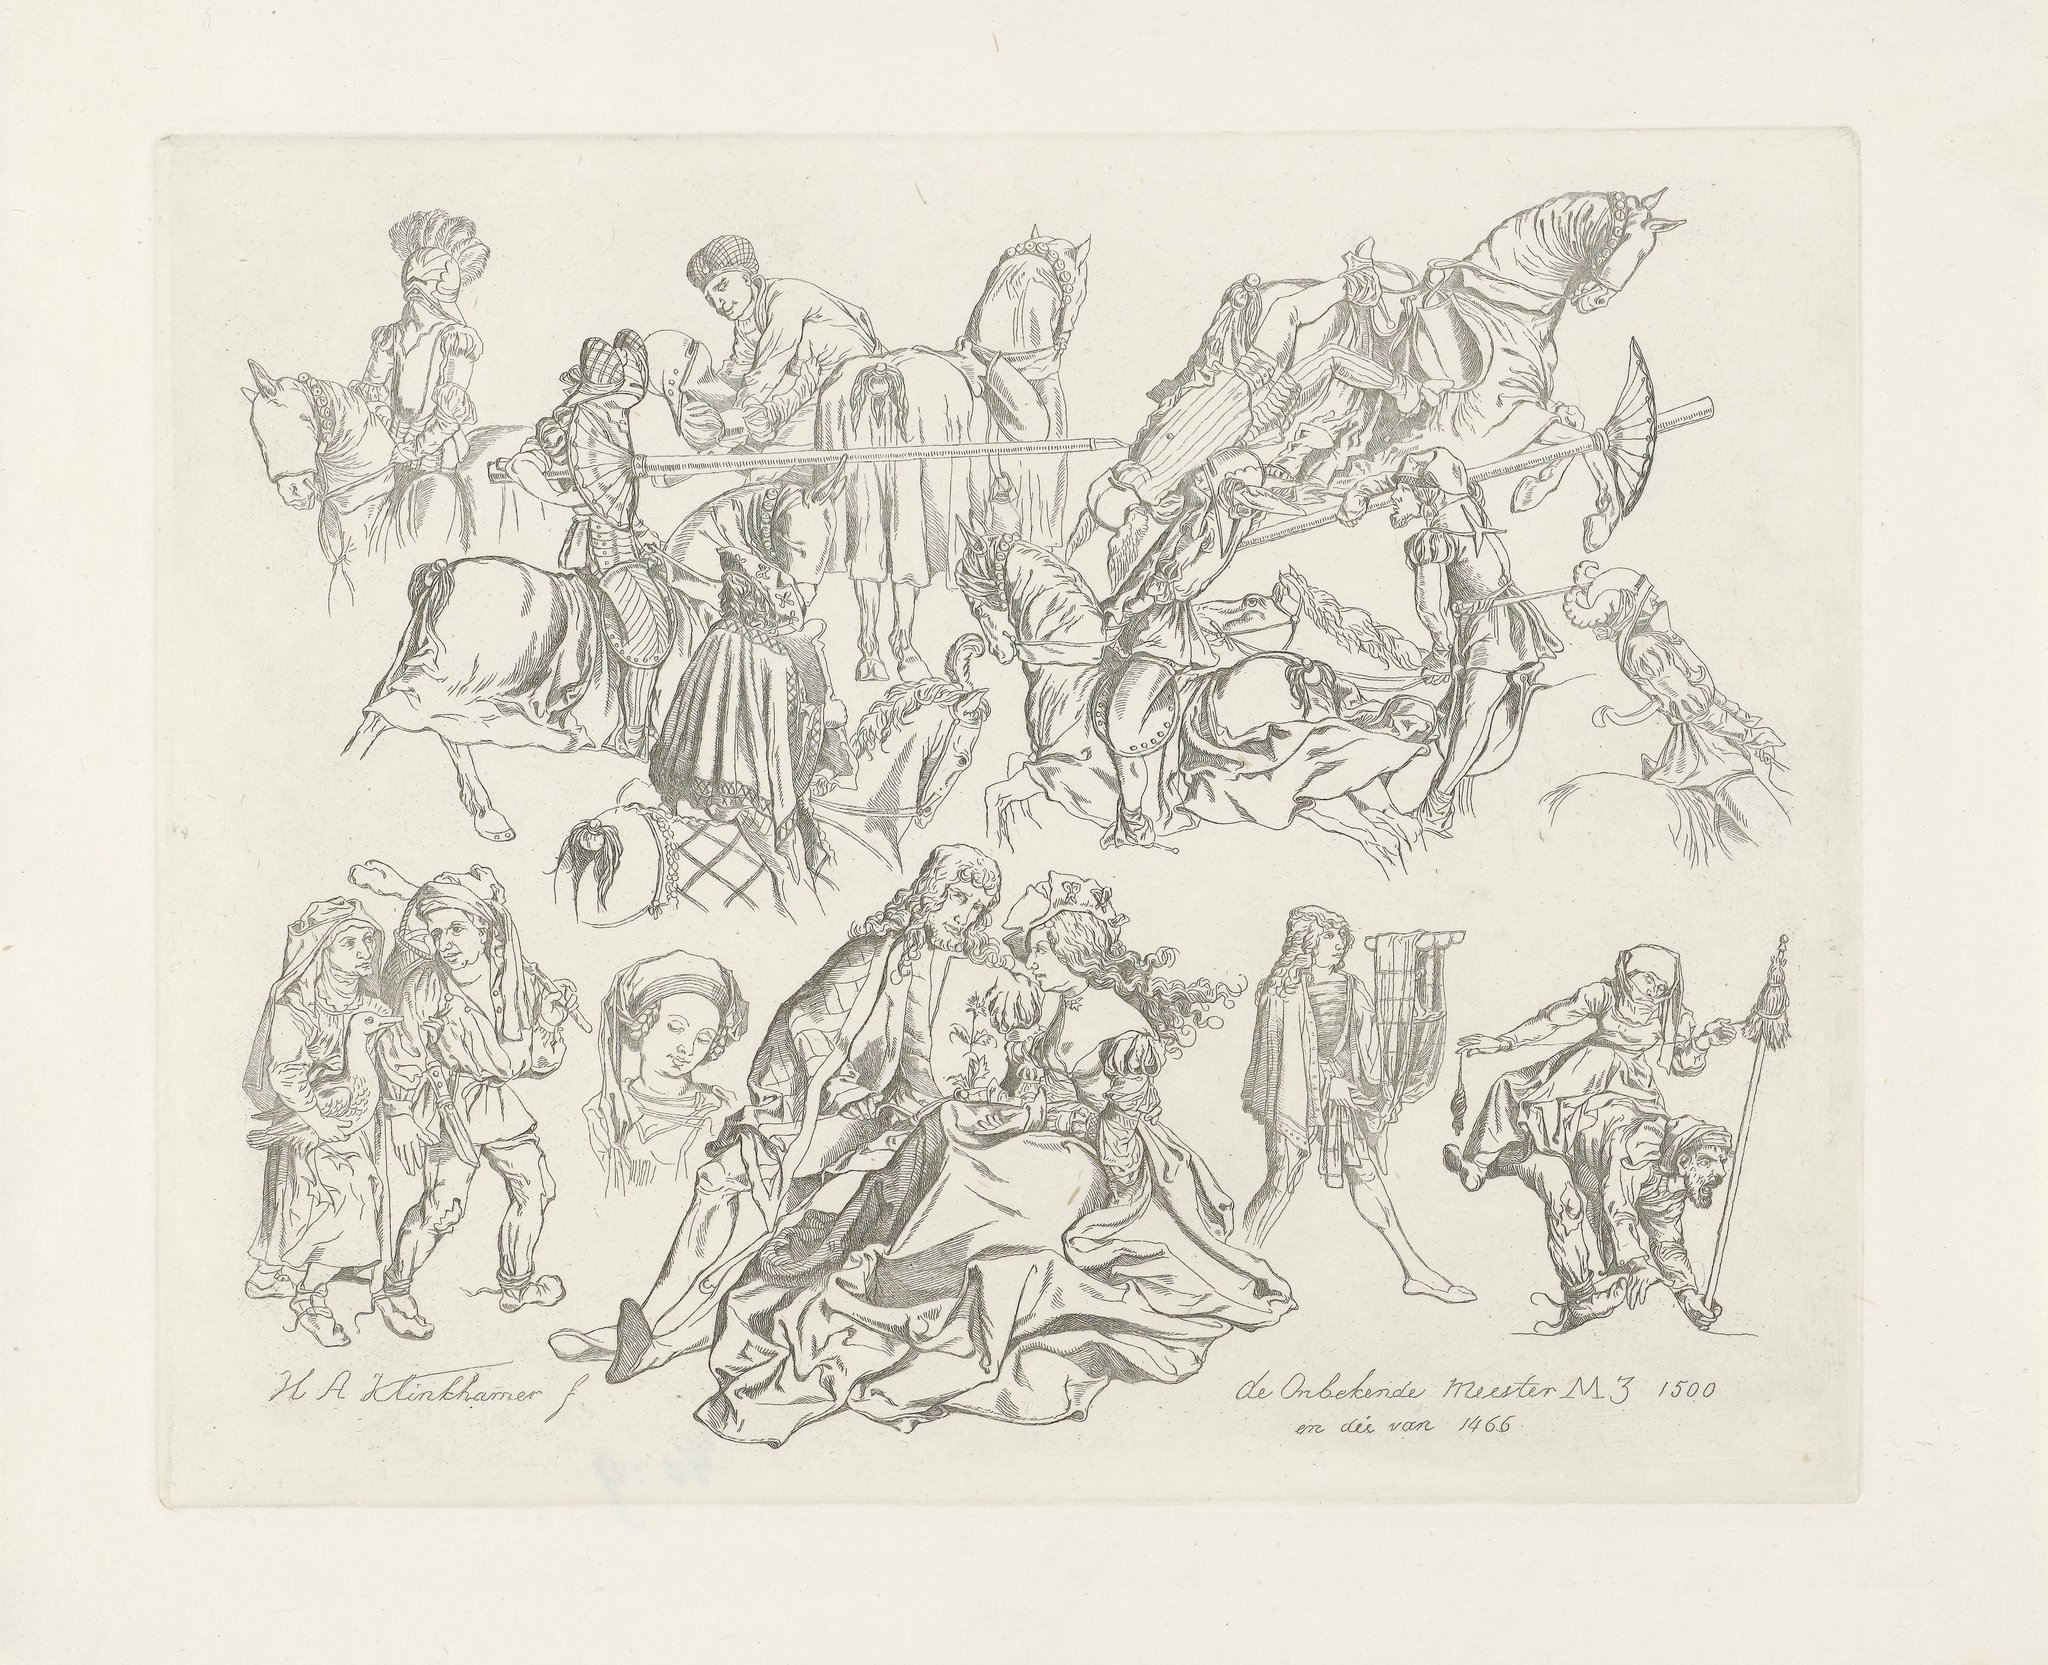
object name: print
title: Studieblad met ruiters en paren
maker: hendrik abraham klinkhamer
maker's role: draughtsman, painter, print maker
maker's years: 1810-1872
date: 1820-1872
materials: paper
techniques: etching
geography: amsterdam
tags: other forms of knights' contests, water-birds: goose, spindle, horse in motion, violent death by lance, spear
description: Studieblad met diverse ruiters en paren in Middeleeuwse kleding. Aan de bovenzijde een aantal ruiters in gevecht. Twee van de ruiters worden met een lans van hun paard gestoken. Linksonder een wandelend paar, waarvan de man een knuppel en vrouw een gans bij zich draagt. Rechts een vrouw die, zittende op de rug van haar man, garen uit een spintol trekt.